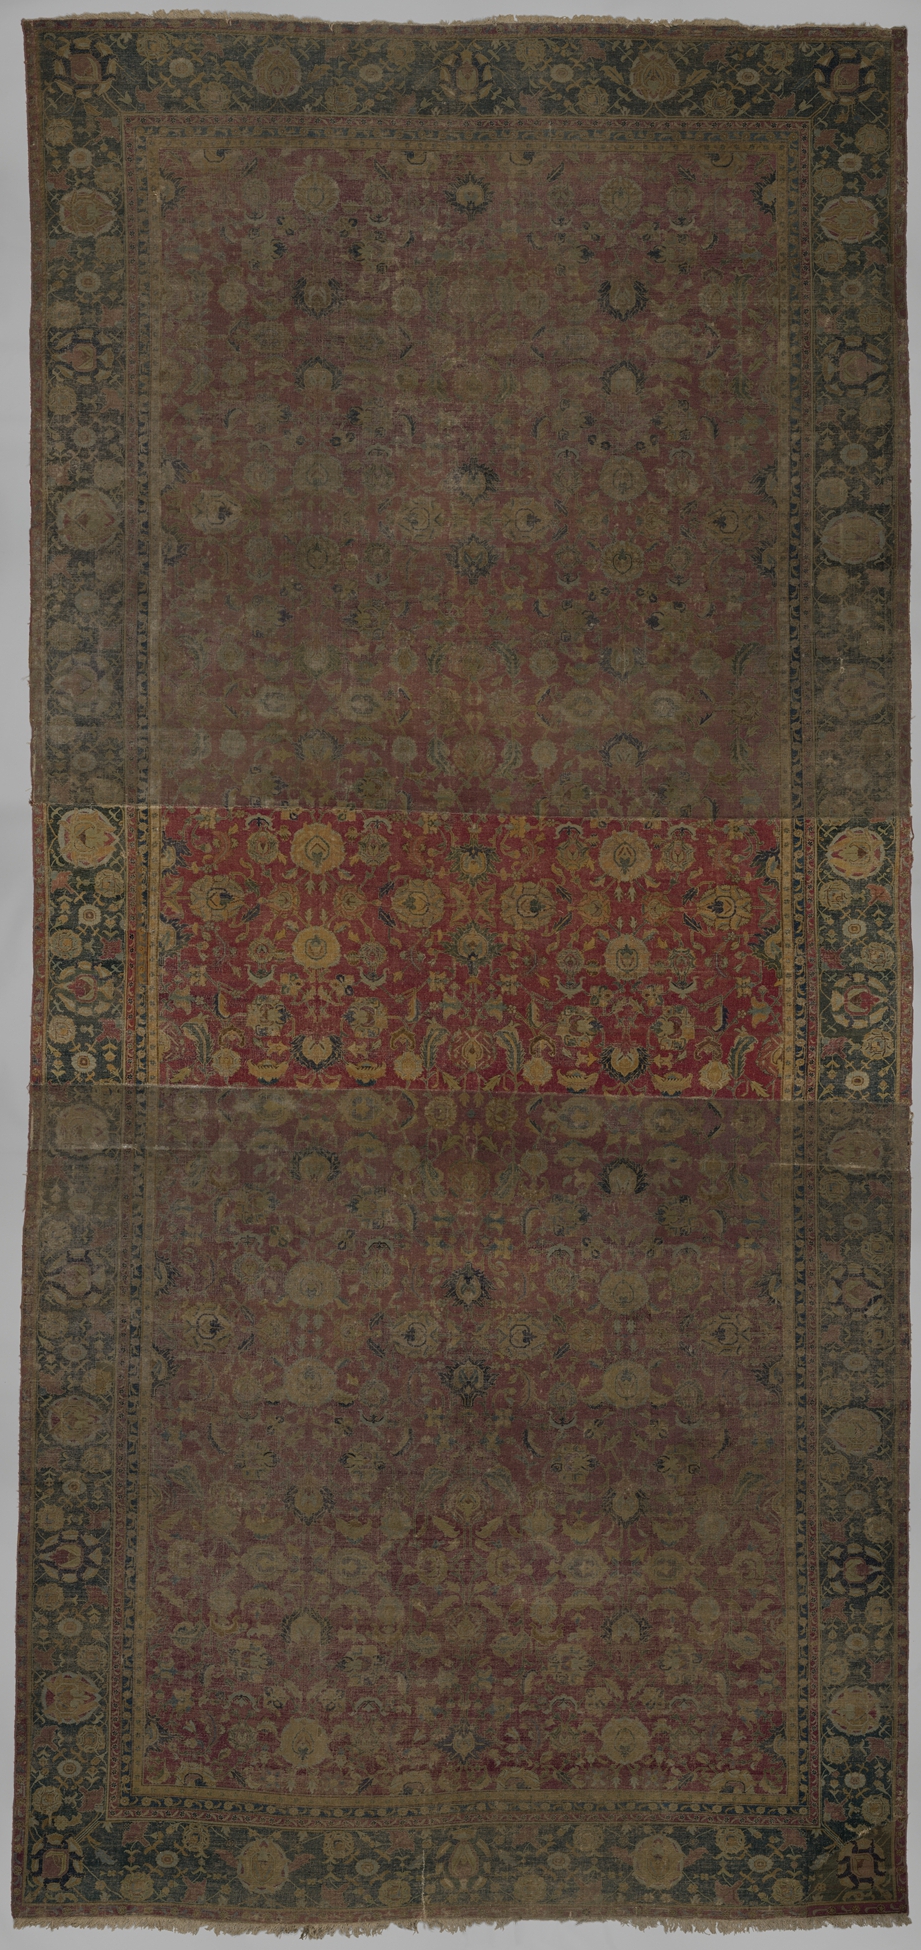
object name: carpet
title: Indo-Persian carpet with repeat pattern of vine scrolls and palmettes.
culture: indo-persian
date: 1651-1700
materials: cotton, wool